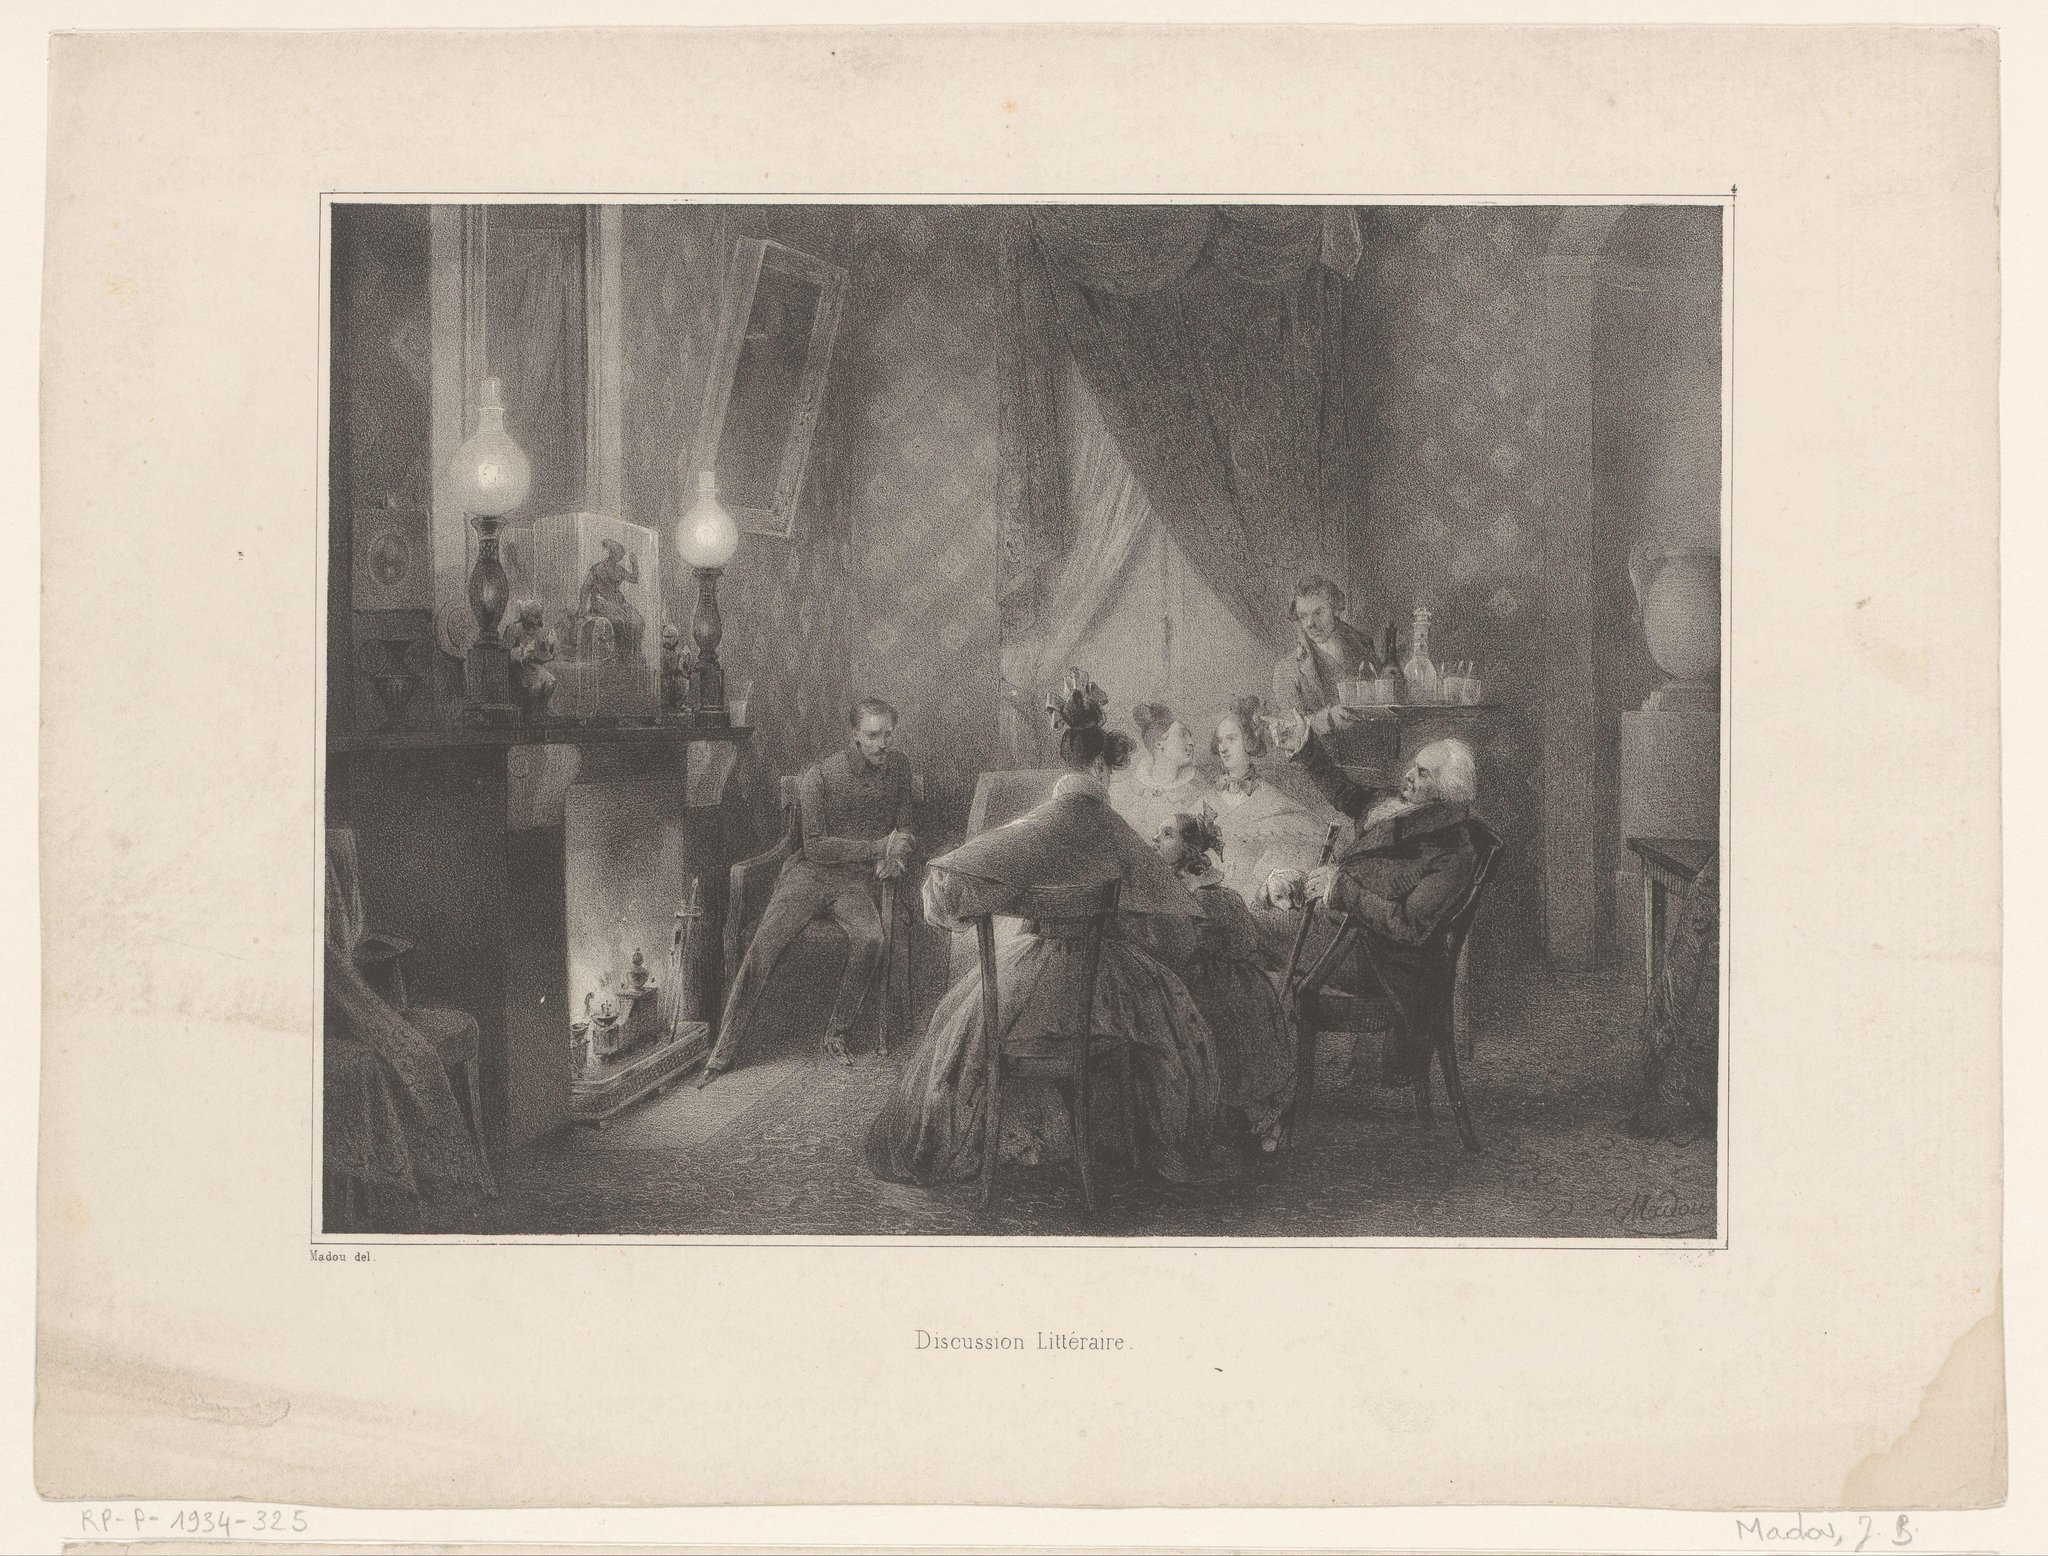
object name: print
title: Belgische familietaferelen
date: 1806-1877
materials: paper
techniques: lithograph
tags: open hearth, fire-place, family life, interior of the house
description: Prent maakt deel uit van een serie met Belgische familietaferelen. Over deze serie is verder niets bekend. Het betreft voornamelijk huiselijke taferelen.